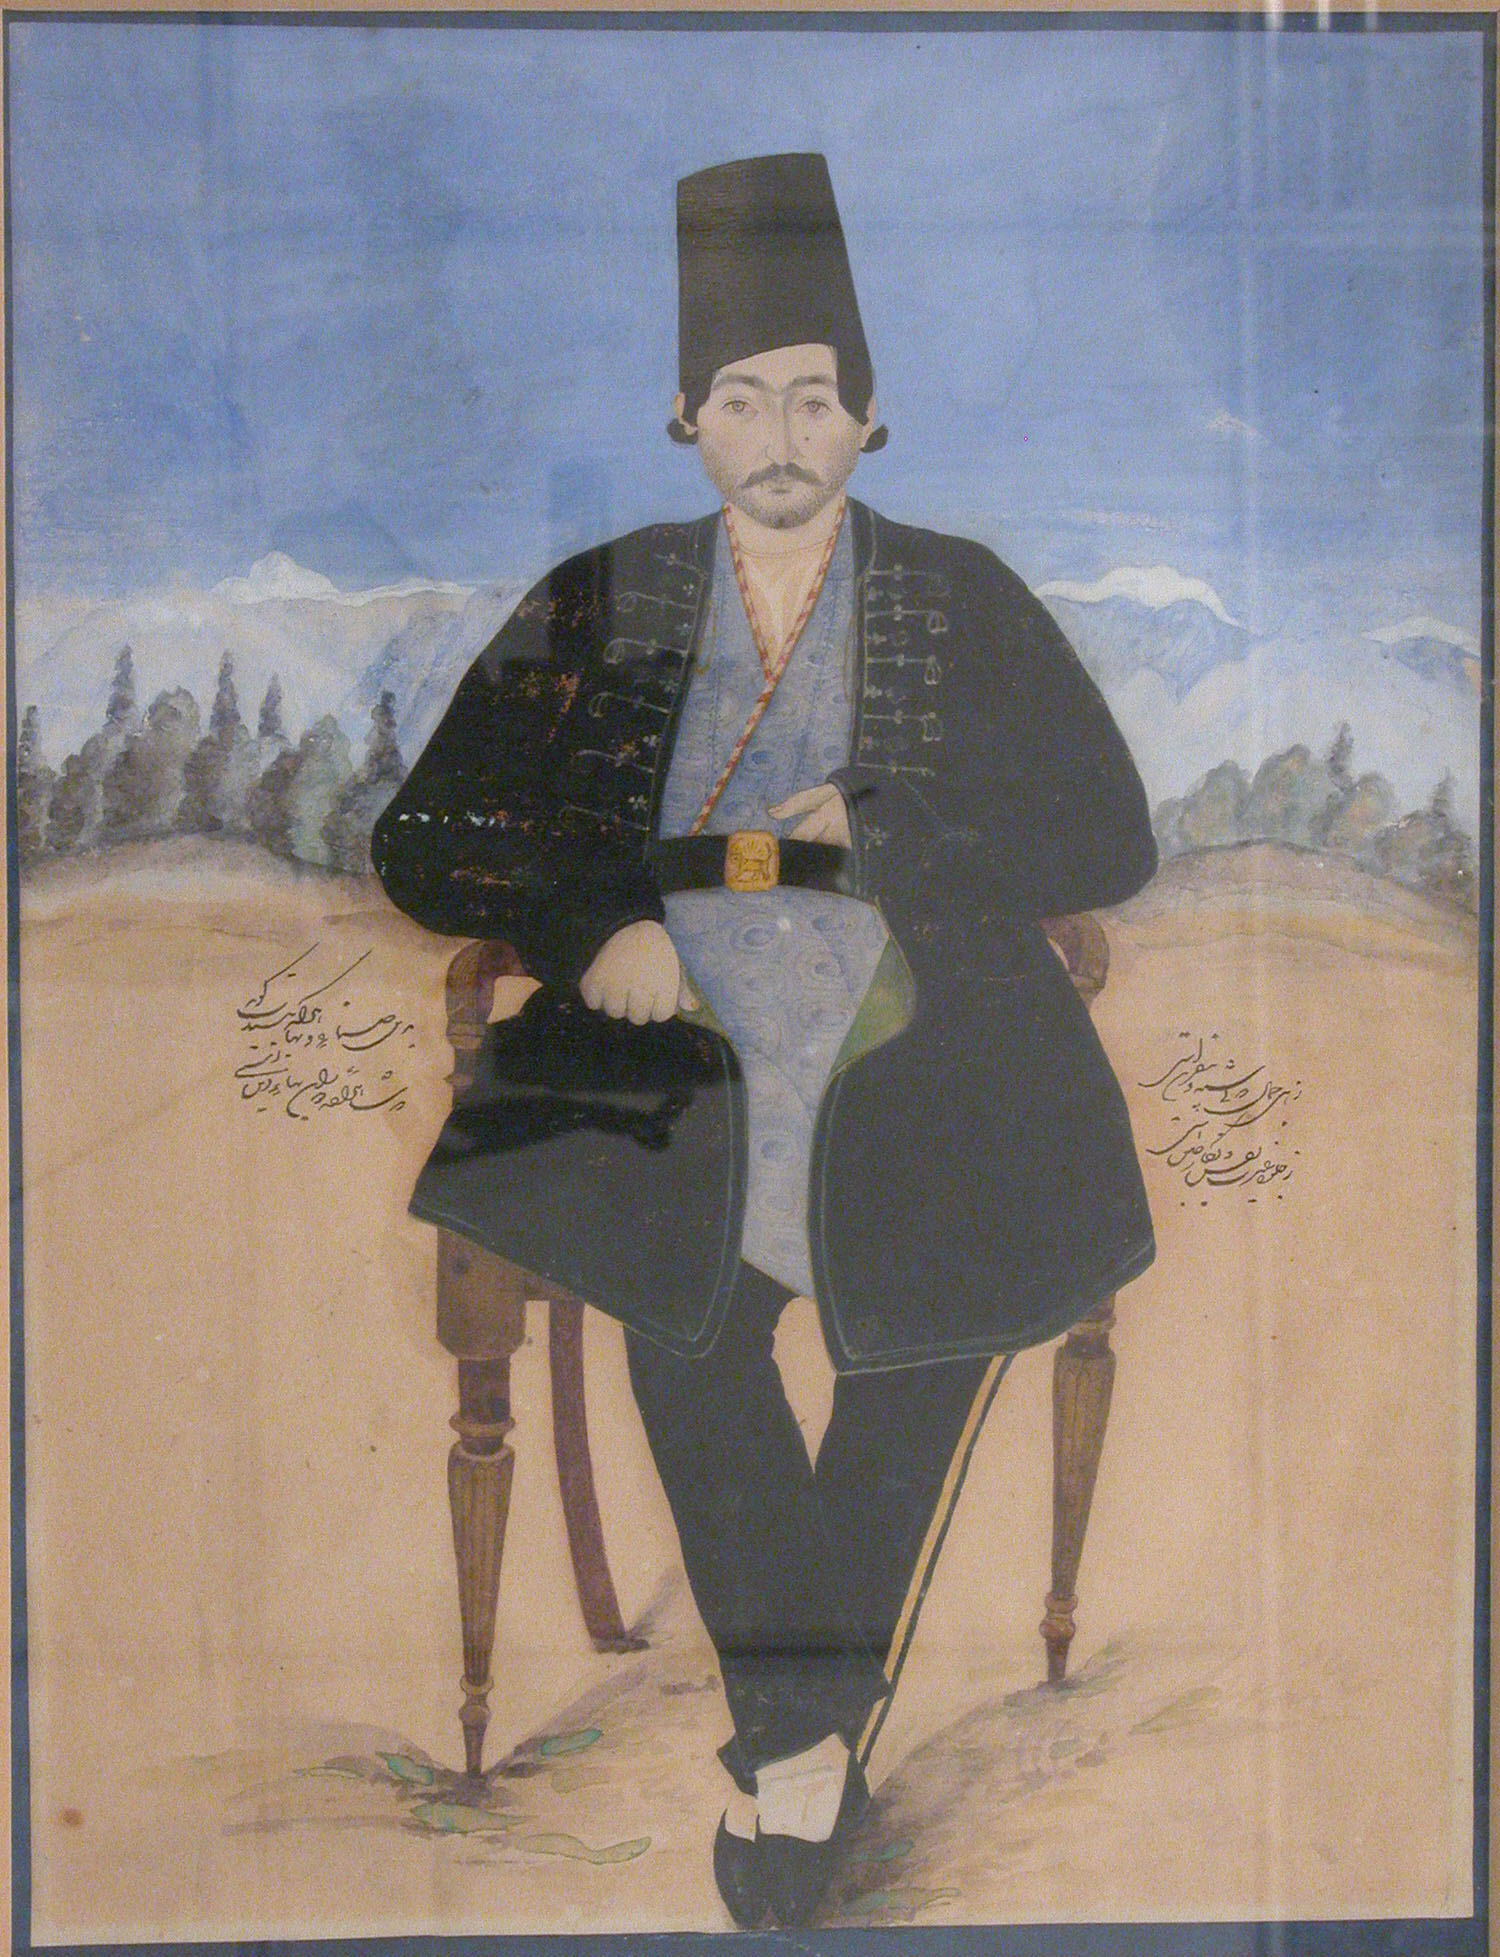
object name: illustrated single work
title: Portrait of a Nobleman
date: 1851-1900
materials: paper, watercolor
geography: iran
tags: men,portraits